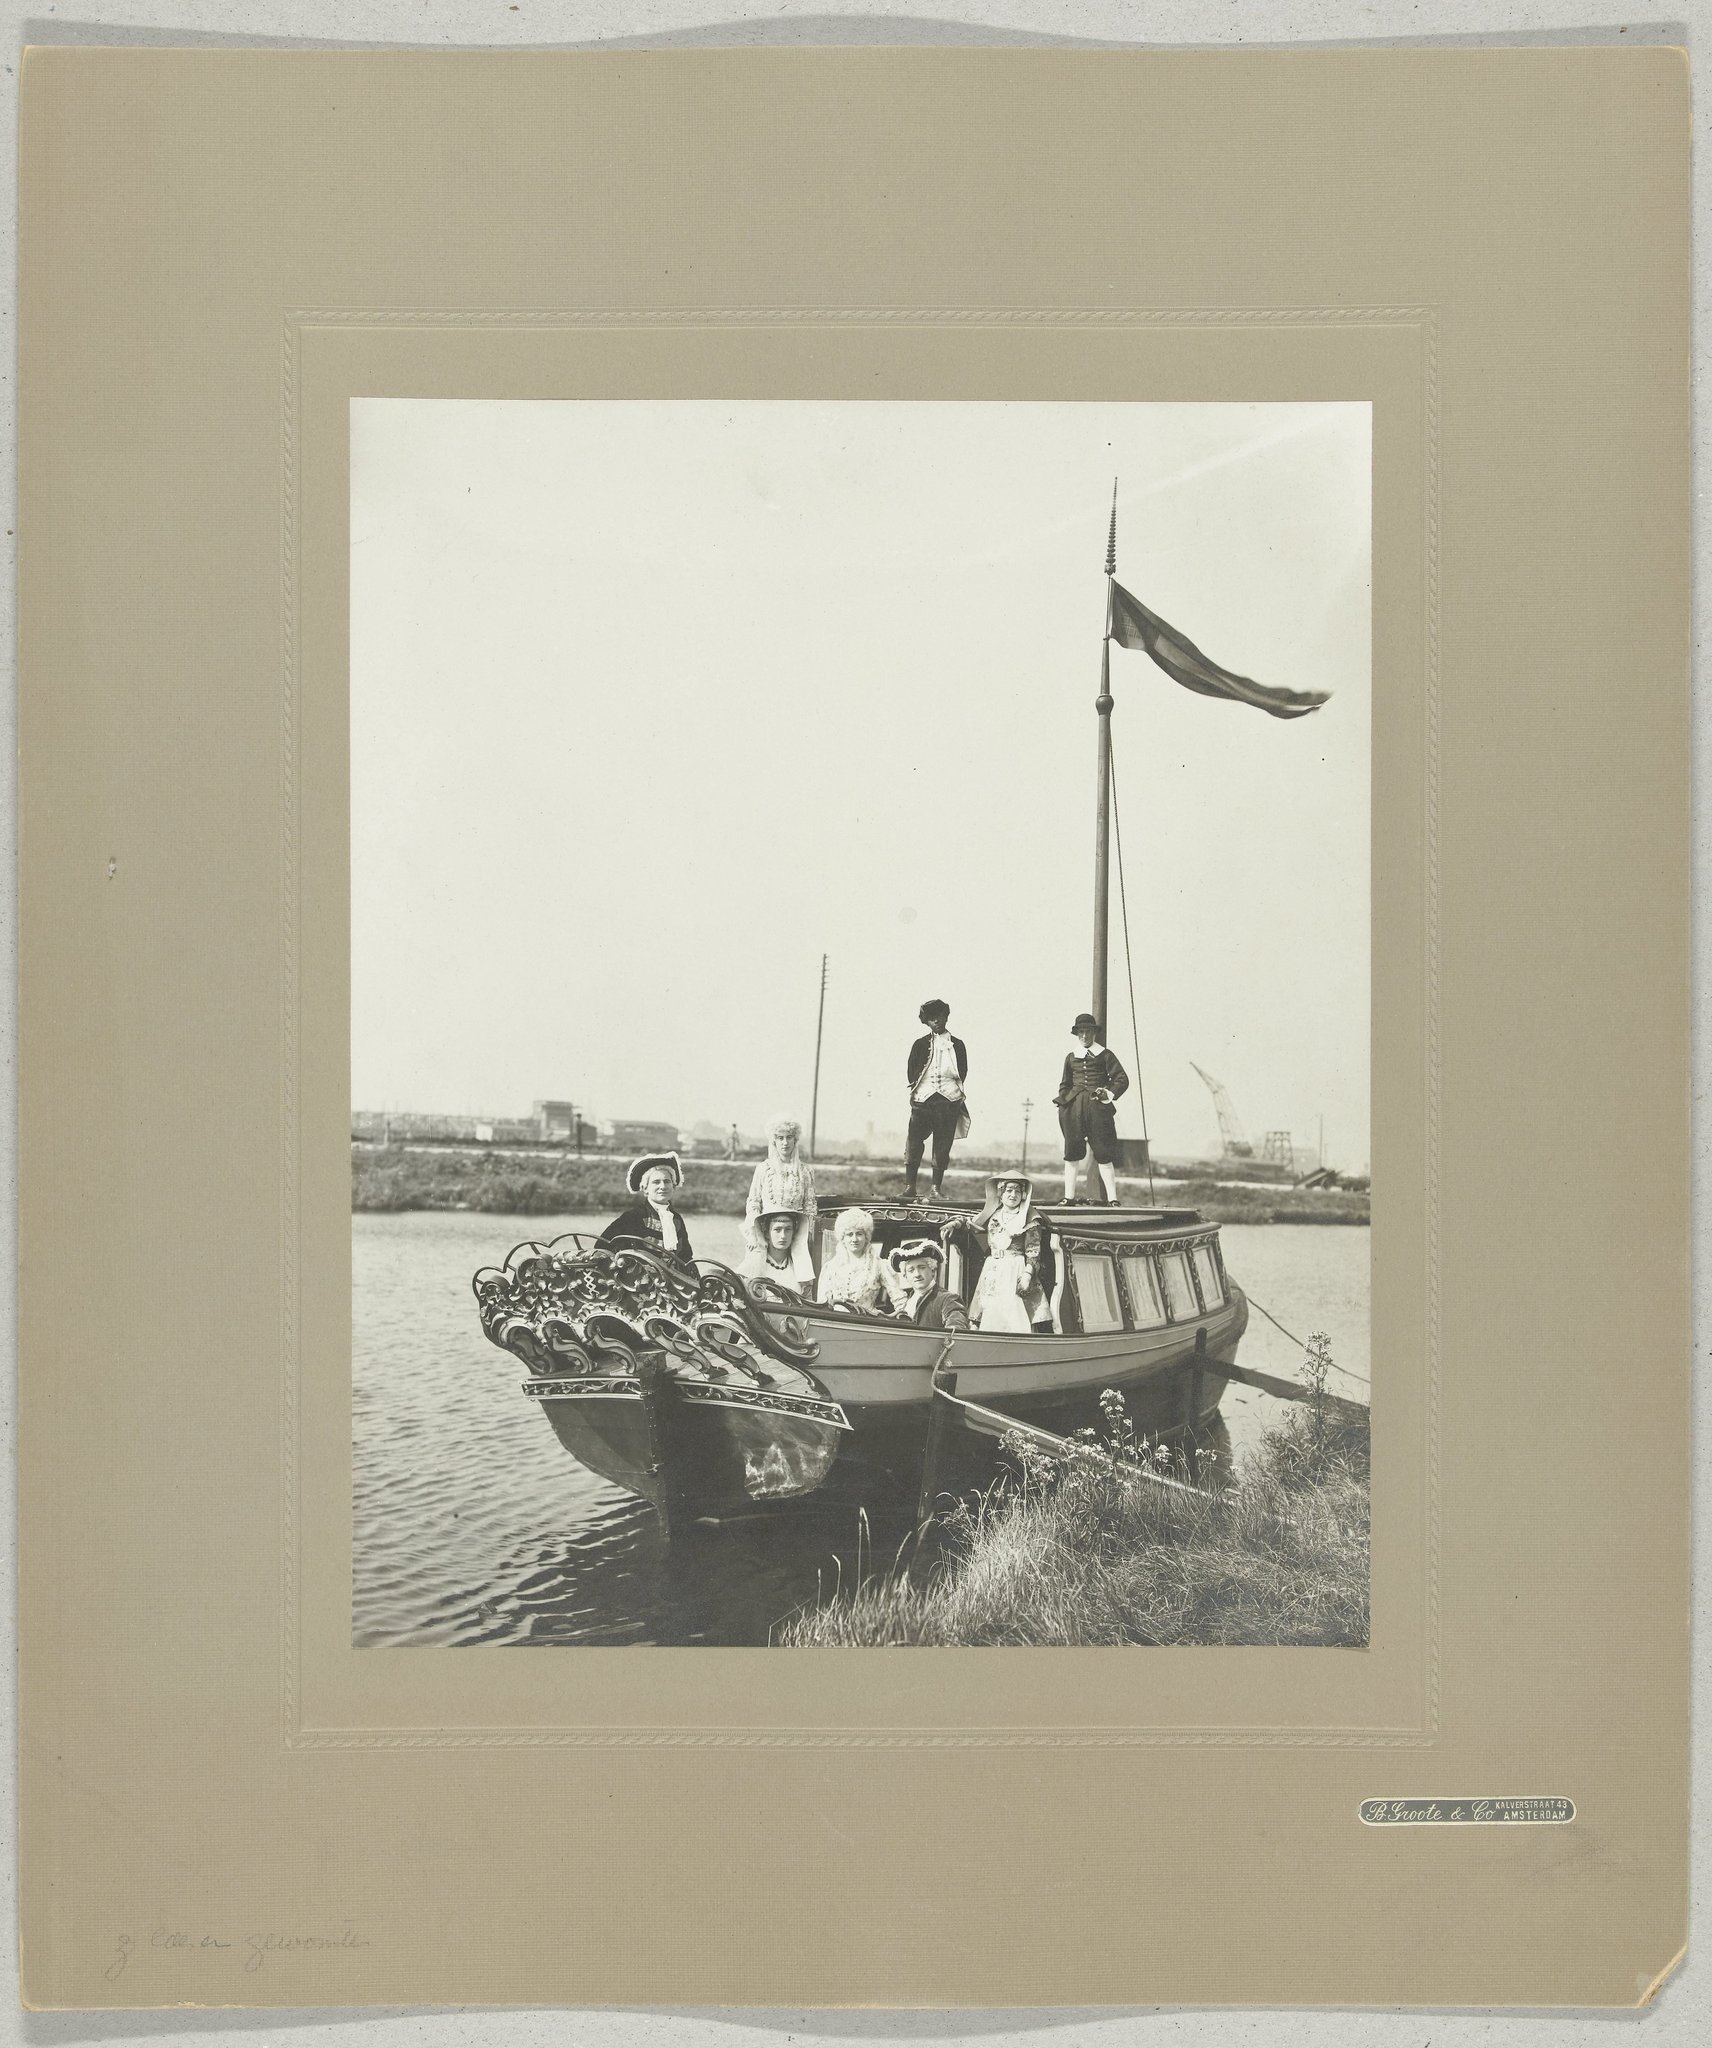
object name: photograph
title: Gezelschap in historisch kostuum in een boot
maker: barend groote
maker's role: fotograaf, fotohandel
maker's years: 1862-1946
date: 1890-1920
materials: cardboard, paper, photographic support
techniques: gelatin silver print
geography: amsterdam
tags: ships (in general), fictitious scene ~ anonymous historical person(s), anonymous historical persons portrayed in a group, in a group-portrait